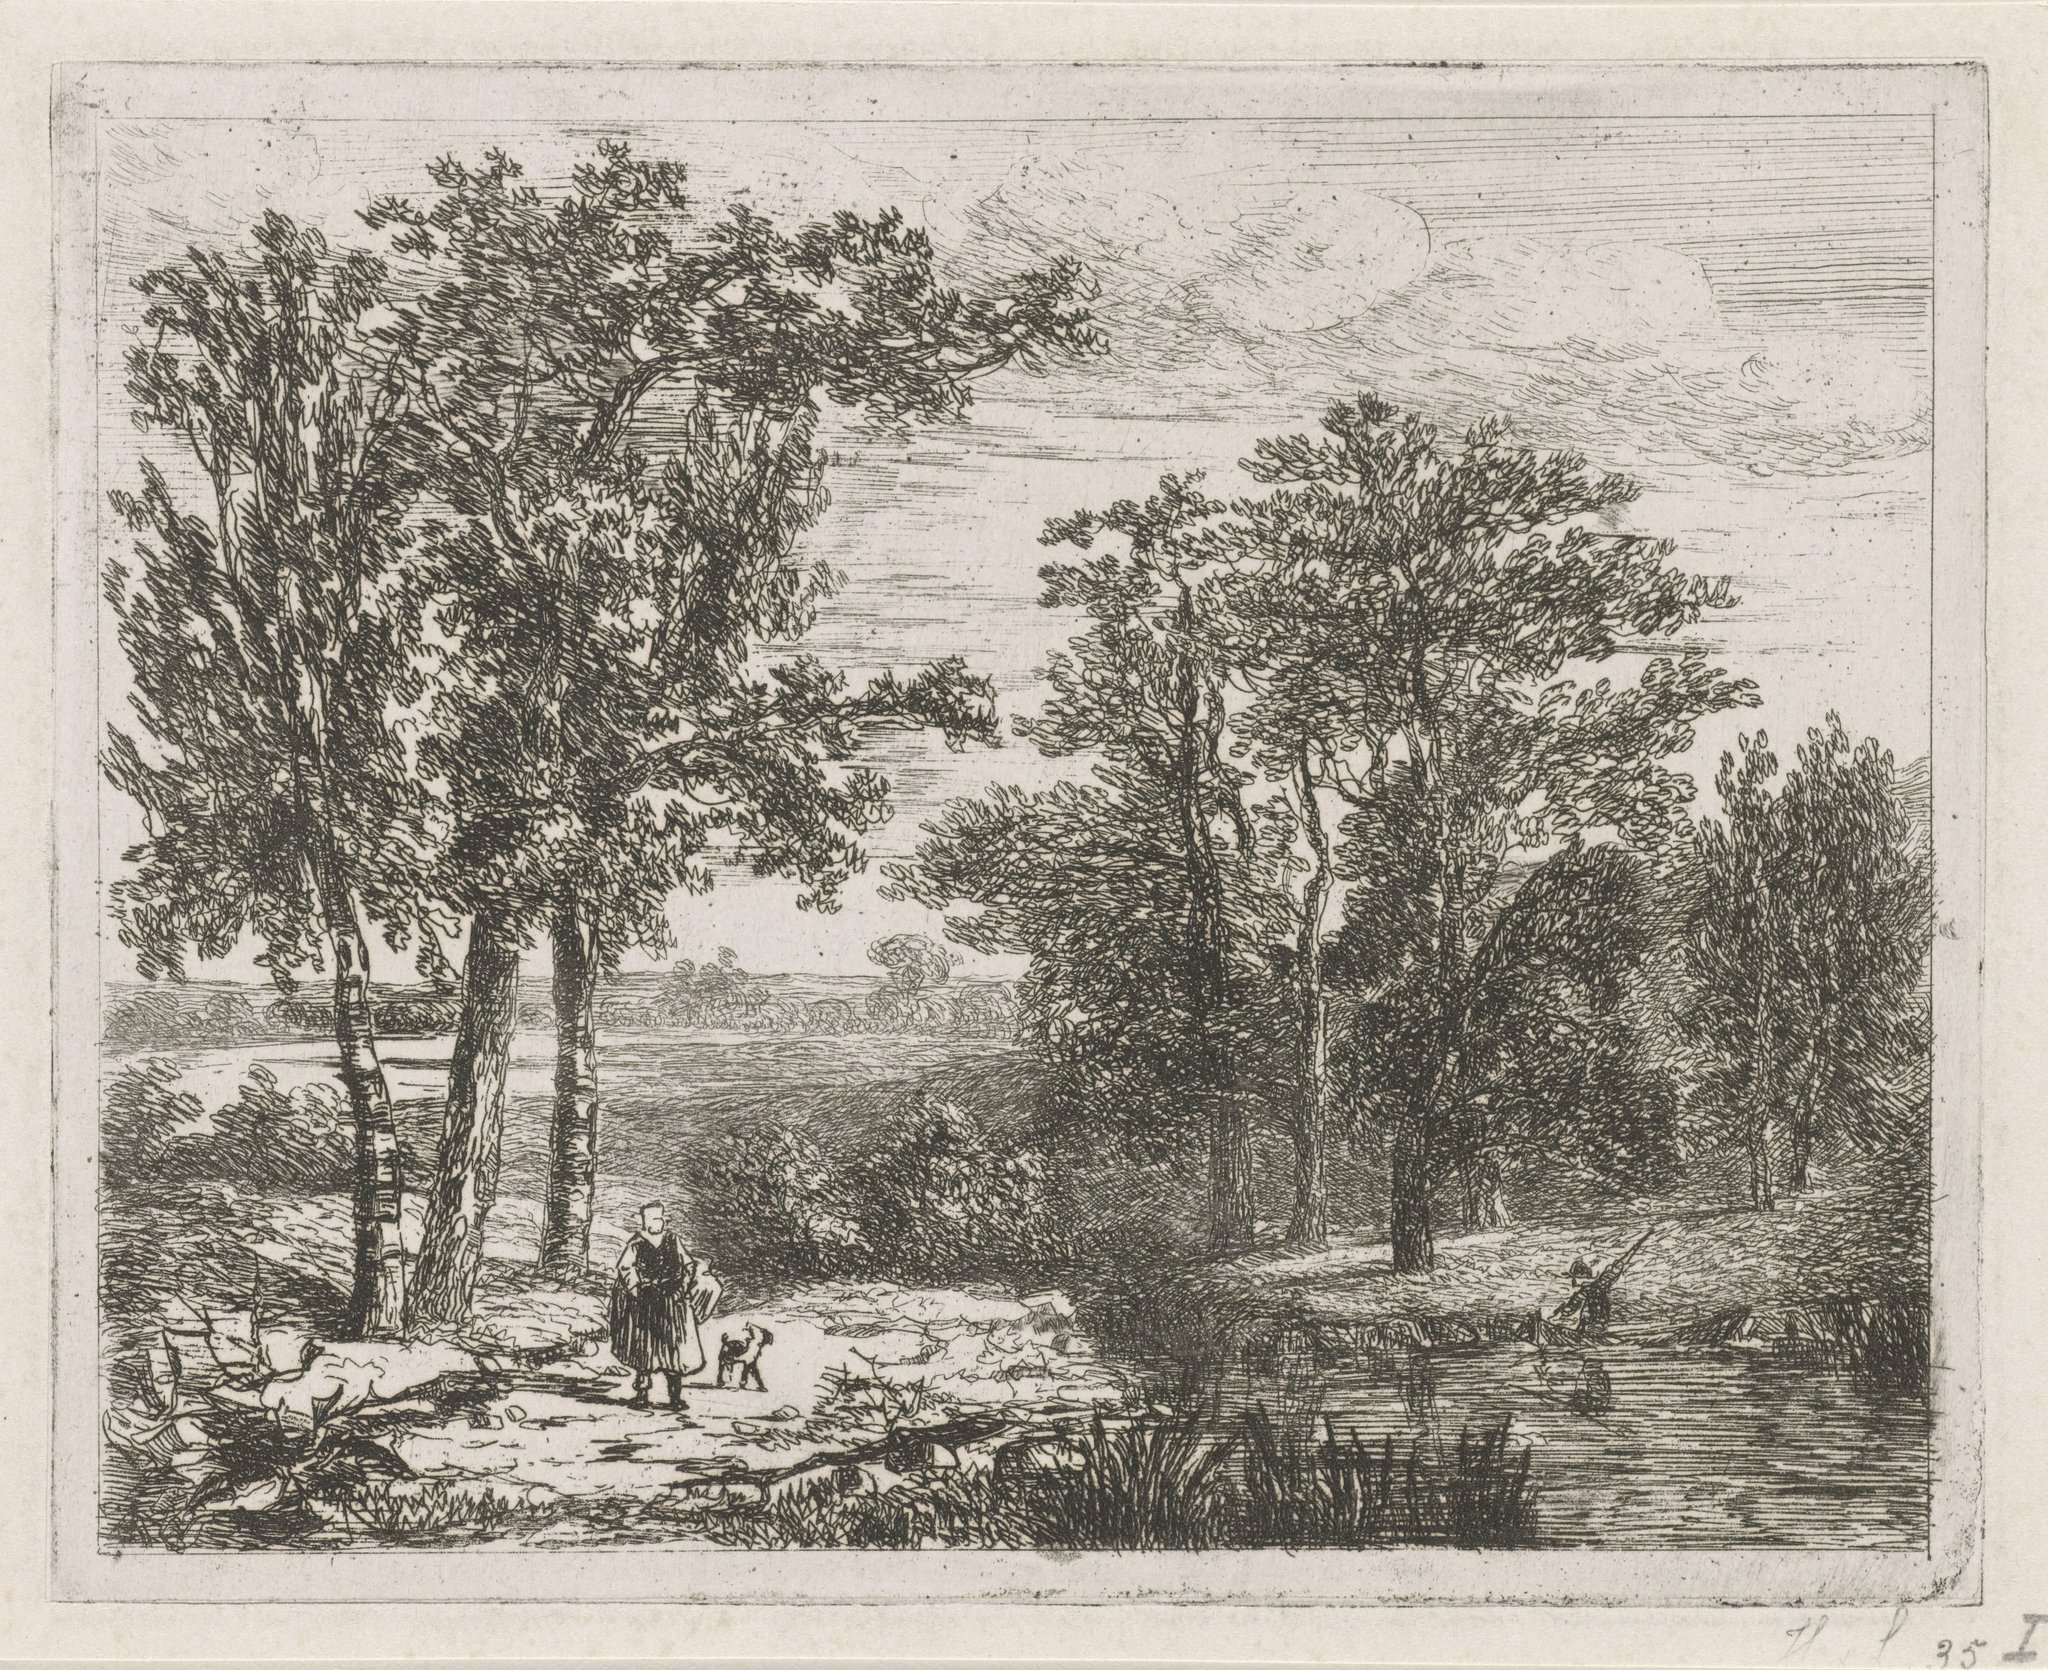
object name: print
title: Vrouw en hond bij de bosrand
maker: hermanus jan hendrik van rijkelijkhuysen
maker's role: painter, print maker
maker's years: 1813-1883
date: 1823-1883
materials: paper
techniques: drypoint, etching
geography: utrecht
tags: forest, wood, pond, pool, fisherman, dog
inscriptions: collector's mark: Lugt 2228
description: Aan de rand van een bos wandelt een vrouw met haar hond langs een meertje. In het water een roeiboot met visser.